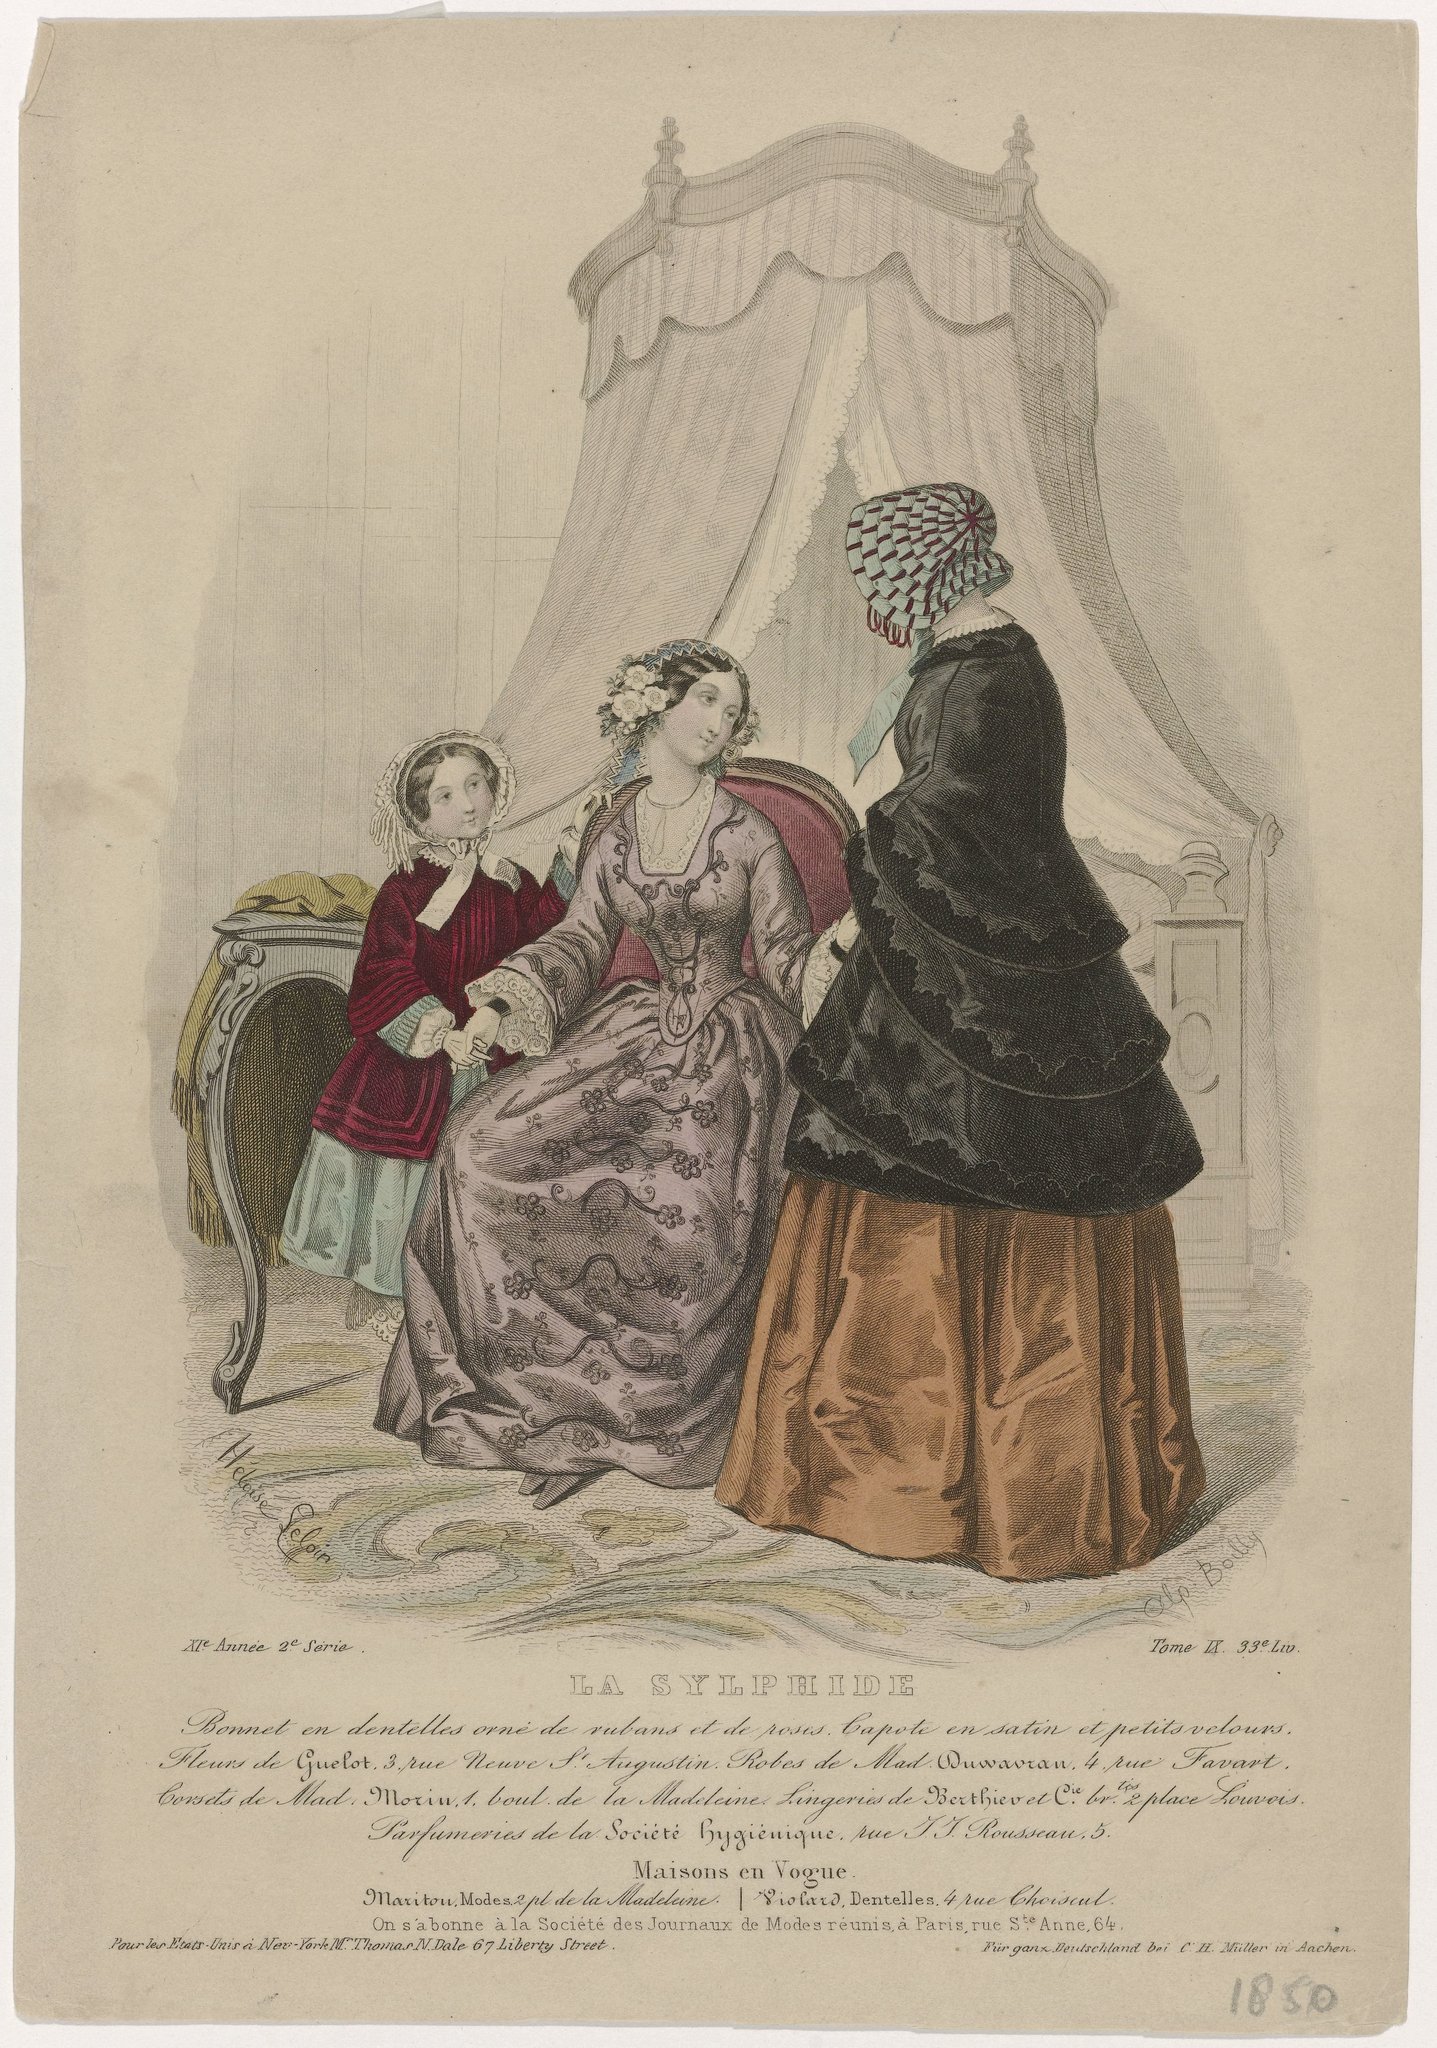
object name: fashion print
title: La Sylphide, 1850, 11e année, 2e serie, tome 9, 33e liv : Bonnet en dentelles (...)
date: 1850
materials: paper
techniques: engraving, hand coloring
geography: paris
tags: skirt (+ girls' clothes), head-gear (capote) (+ women's clothes), head-gear: cap (+ lace used for clothes), border, ribbon, braid (+ women's clothes), bed with tester, coat (+ women's clothes), coat (+ girls' clothes), head-gear: cap (+ women's clothes), fashion plates, flowers: rose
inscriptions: address: ‘On s'abonne à la Société des Journaux de Modes réunis, à Paris, rue S.te Anne, 64. / Pour les Etats-Unis à New-York M.r Thomas N. Dale 67 Liberty Street. / Für ganz Deutschland bei C.H. Müller in Aachen.’, title: ‘La Sylphide’, caption: ‘Bonnet en dentelles orné de rubans et de roses. Capote en satin et petits velours. Fleurs de Guelot, 3. rue Neuve S.t Augustin. Robes de Mad. Duwavran,4 rue Favart. Corsets de Mad, Morin,1, boul. de la Madeleine. Lingeries de Berthier et C.ie br. tis 2 place Louvois. Parfumeries de la Société Hygiénique. rue J.J. Rousseau, 5. / Maisons en Vogue. / Mariton, Modes 2 pl de la madeleine. / Violard, Dentelles, 4 rue Choiseul.’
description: Twee vrouwen en een meisje in een interieur. Op de achtergrond een hemelbed. Onder de voorstelling enkele regels reclametekst voor verschillende producten en enkele regels informatie over het modetijdschrift. Prent uit het modetijdschrift La Sylphide (1839-1885).